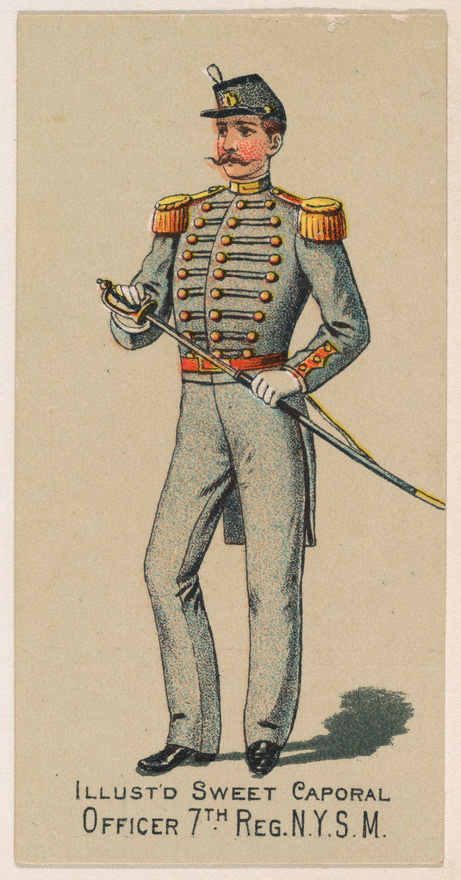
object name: print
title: Officer, 7th Regiment, New York State Militia, from the Military Series (N224) issued by Kinney Tobacco Company to promote Sweet Caporal Cigarettes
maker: kinney brothers tobacco company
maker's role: publisher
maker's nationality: american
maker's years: 1869-2011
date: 1888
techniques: color lithograph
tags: military,men